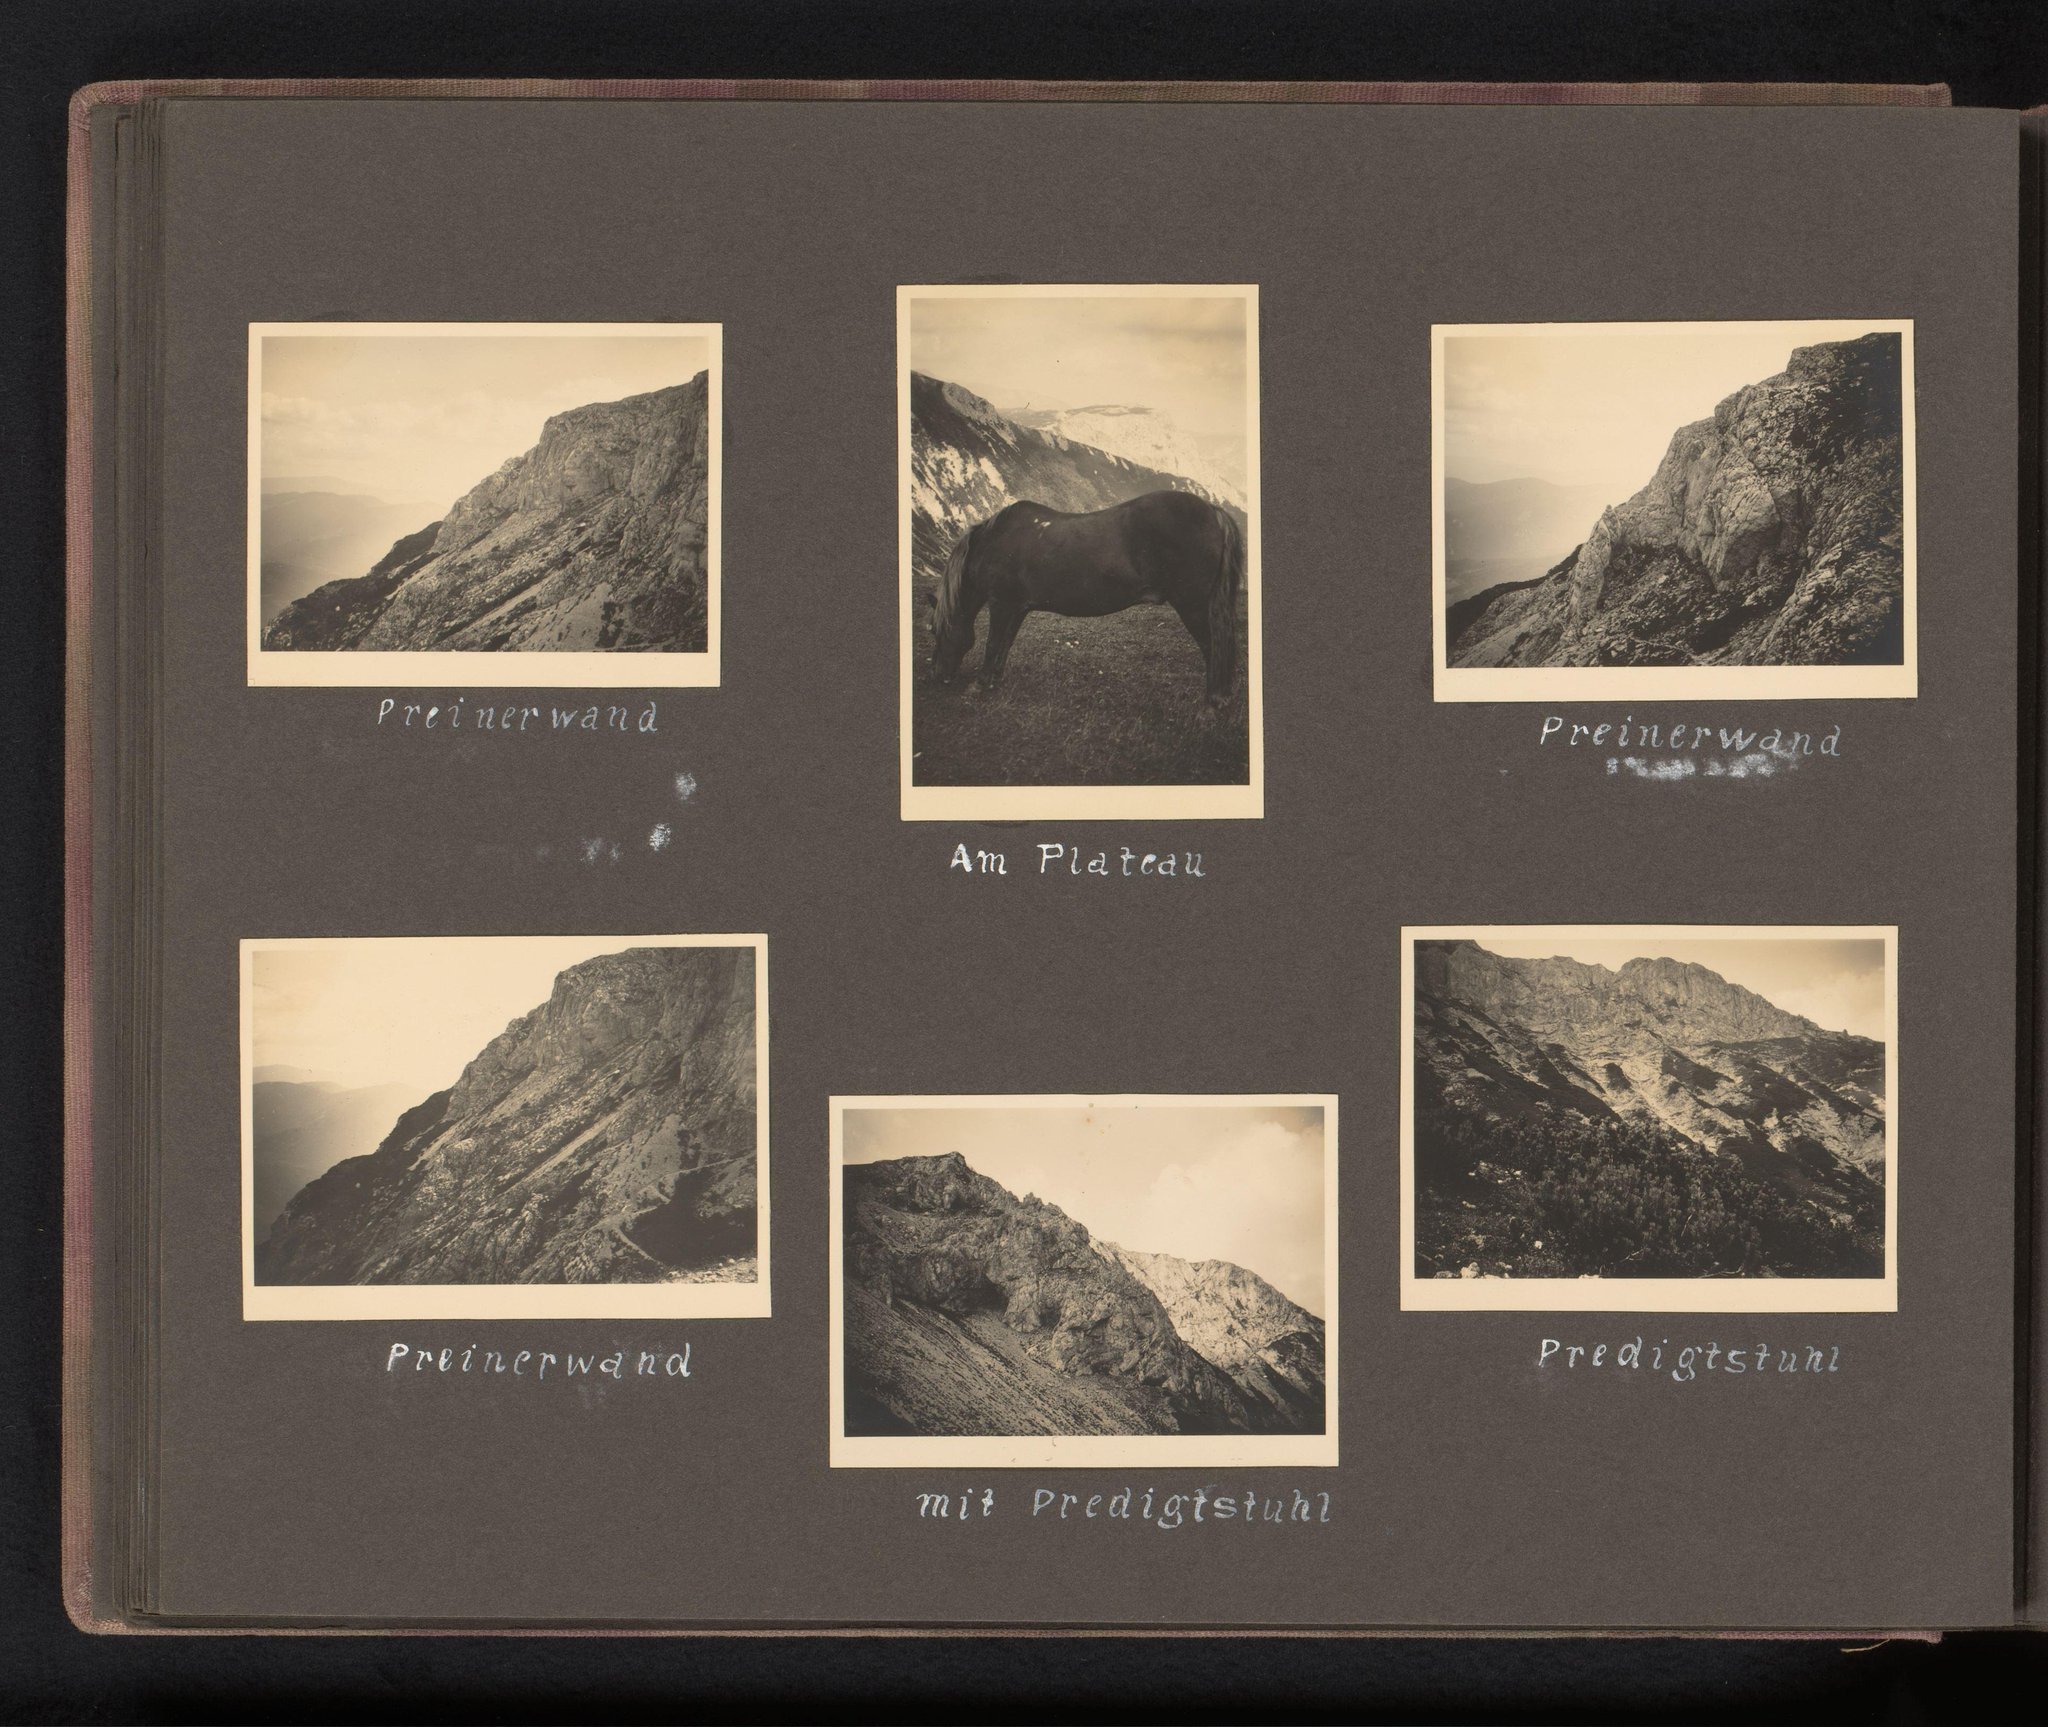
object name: album leaf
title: Trektocht in de Oostenrijkse Alpen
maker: berti hoppe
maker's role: fotograaf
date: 1908-1930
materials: cardboard, photographic support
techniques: gelatin silver print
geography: alps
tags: horse, mountains, austria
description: Zes berglandschappen, waarvan één met een paard. In de onderschriften van de foto's zijn de plaatsen vermeld die te zien zijn: Preinerwand, Predigtstuhl en Plateau. Deze foto's maken deel uit van een album.